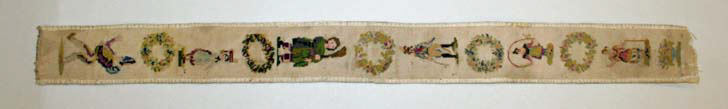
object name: suspender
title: Suspenders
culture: european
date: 1801-1900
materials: silk